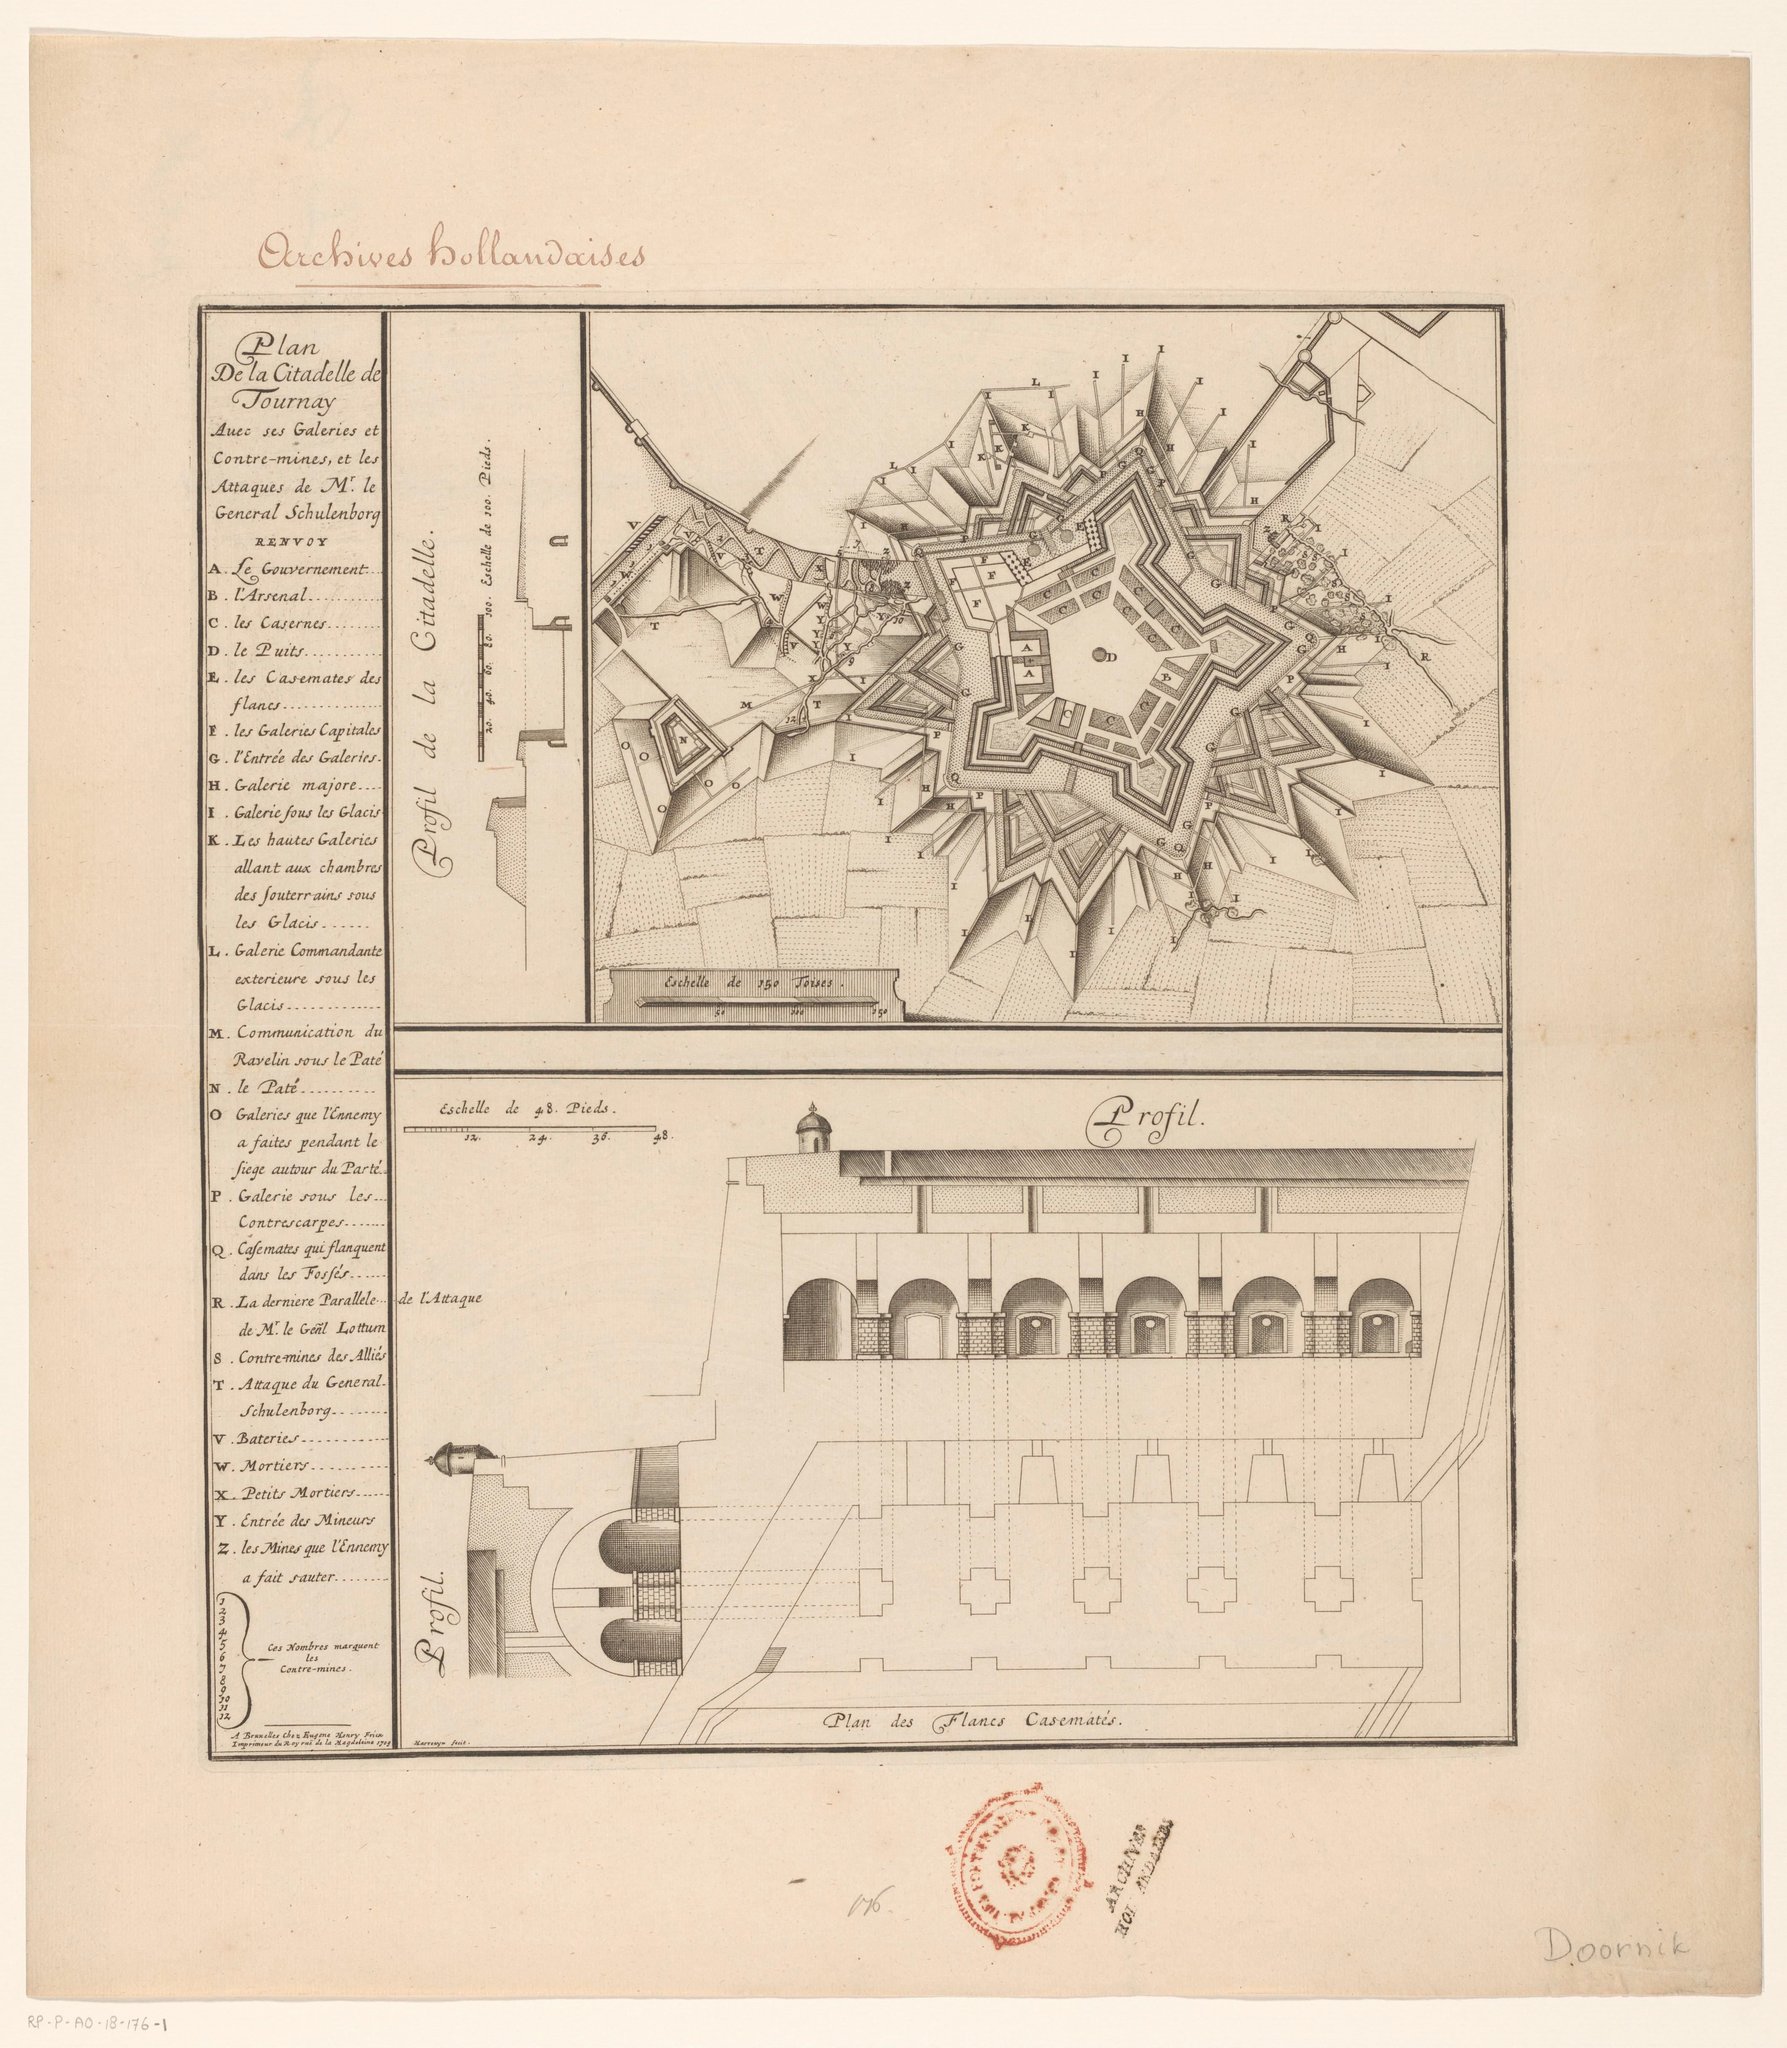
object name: area plan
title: Plan de la citadelle de Tournay avec ses galeries et contre-mines, et les attaques de Mr. le general Schulenborg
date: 1709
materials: paper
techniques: engraving, etching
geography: brussels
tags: fortress, maps of cities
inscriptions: collector's mark: ‘DEPOT GENERAL DES FORTIFICATIONS’, collector's mark: ‘ARCHIVES HOLLANDAISES’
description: Plattegrond en doorsnede van de citadel van Tournai (Doornik), belegerd door de Geallieerden vanaf 29 juni en ingenomen op 2 september 1709. Links de legenda A-Z in het Frans.